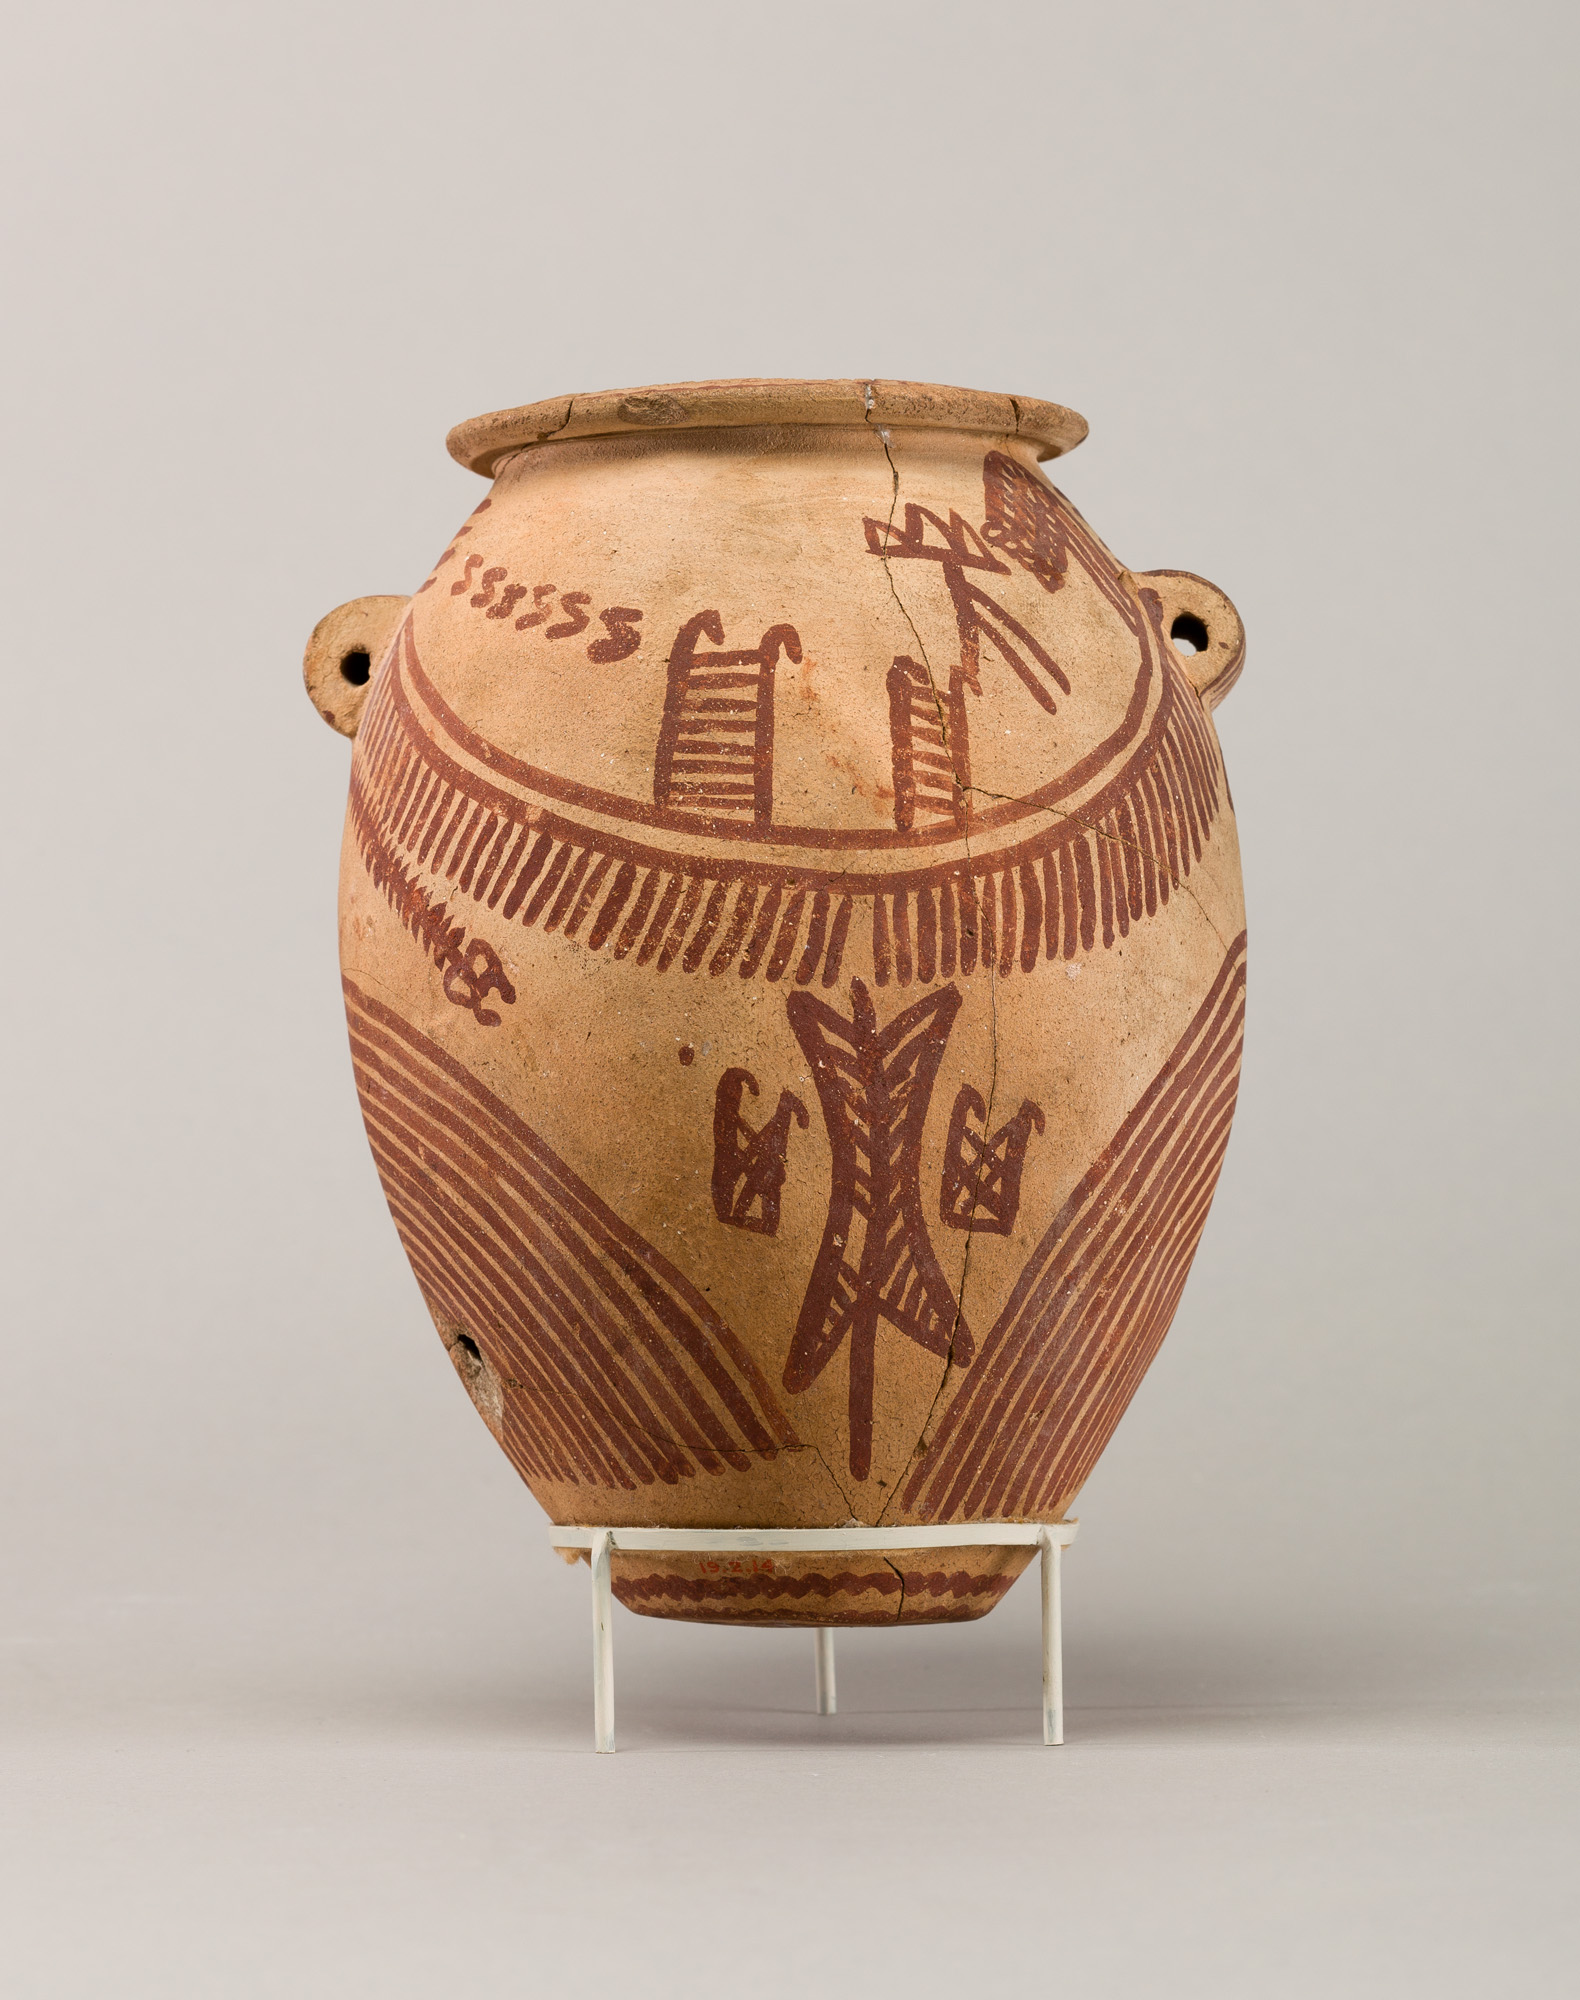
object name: jar, boat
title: Decorated ware jar illustrating boats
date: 3850-2960 BCE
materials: paint, pottery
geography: egypt